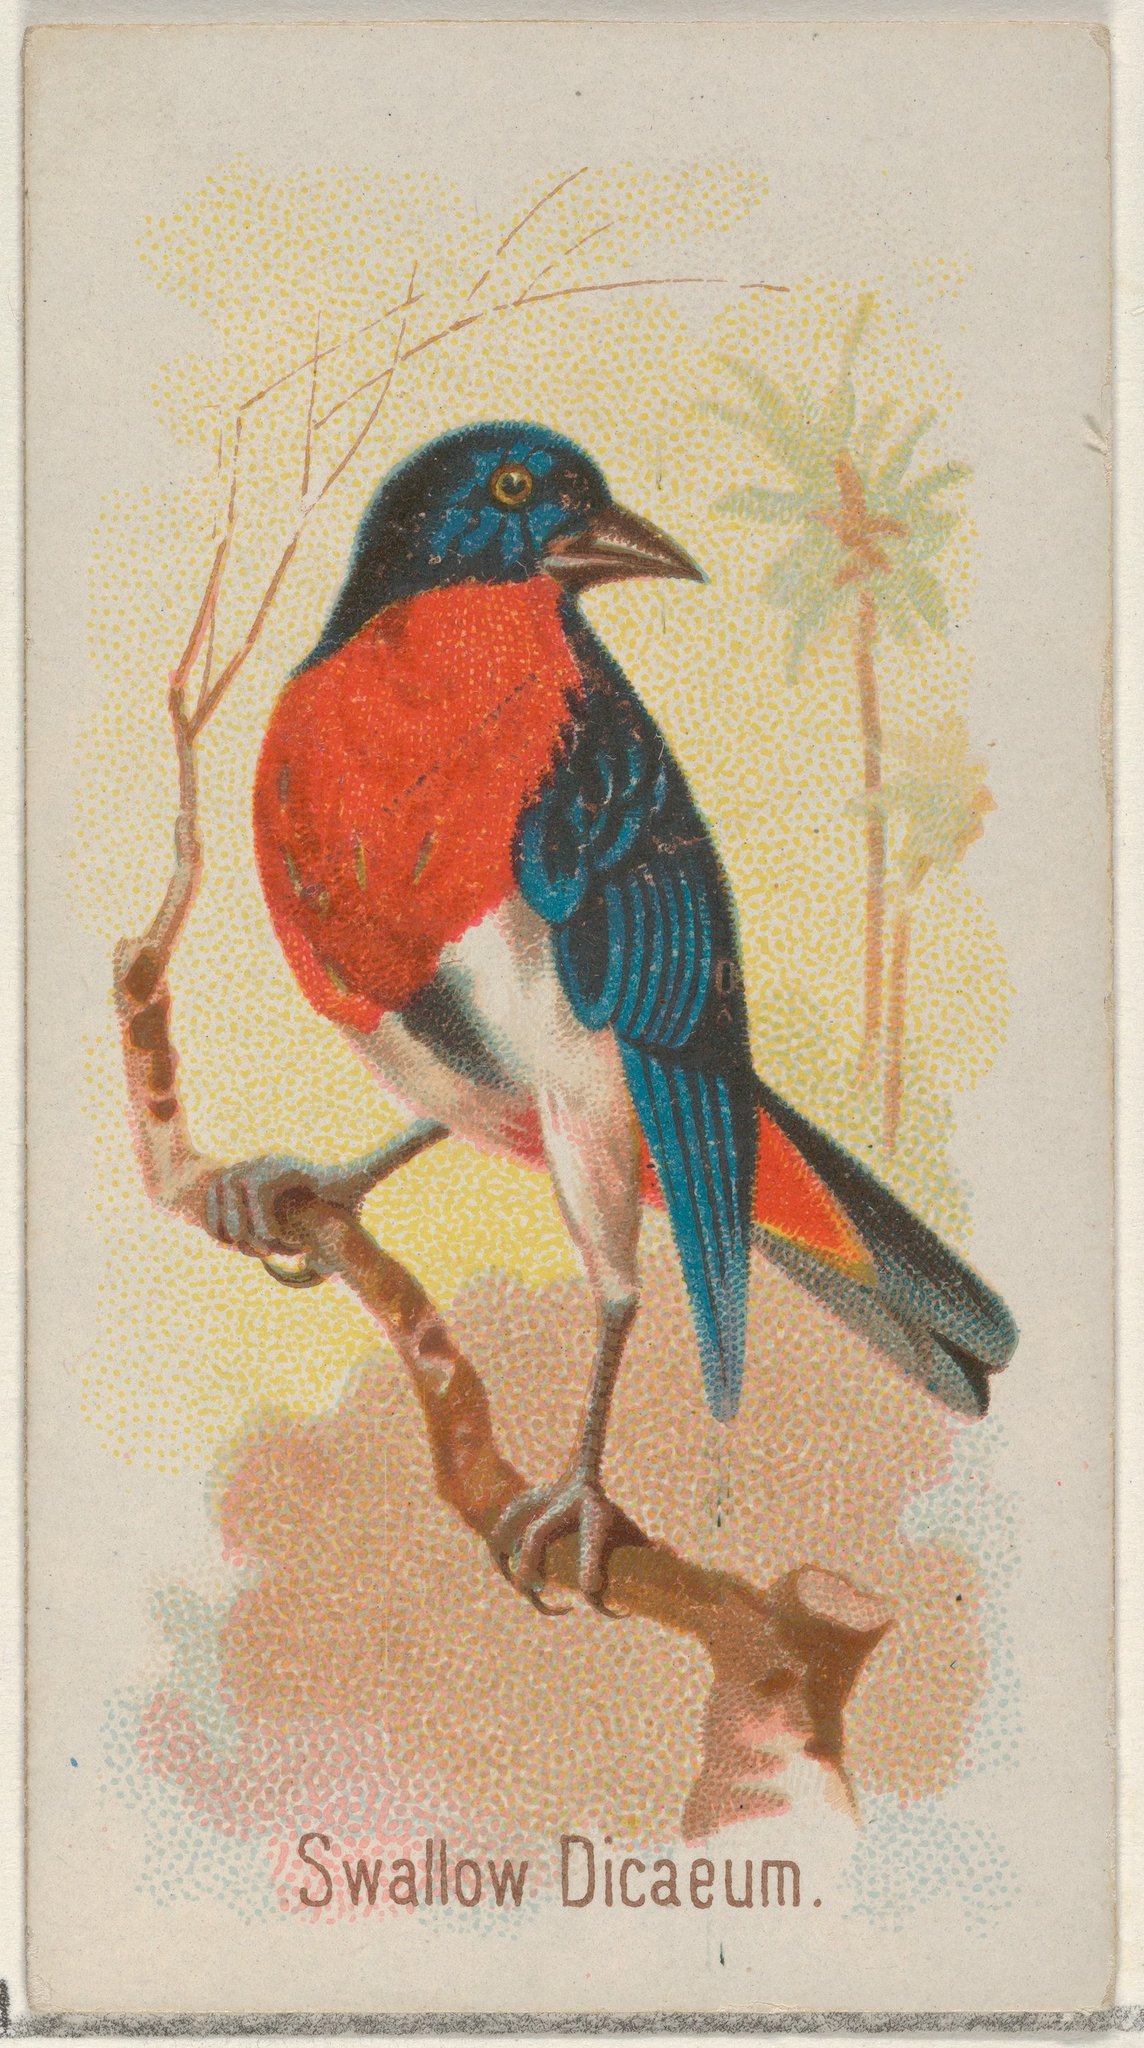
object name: print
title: Swallow Dicaeum, from the Song Birds of the World series (N23) for Allen & Ginter Cigarettes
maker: allen & ginter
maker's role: publisher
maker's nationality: american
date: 1890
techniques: color lithograph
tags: birds